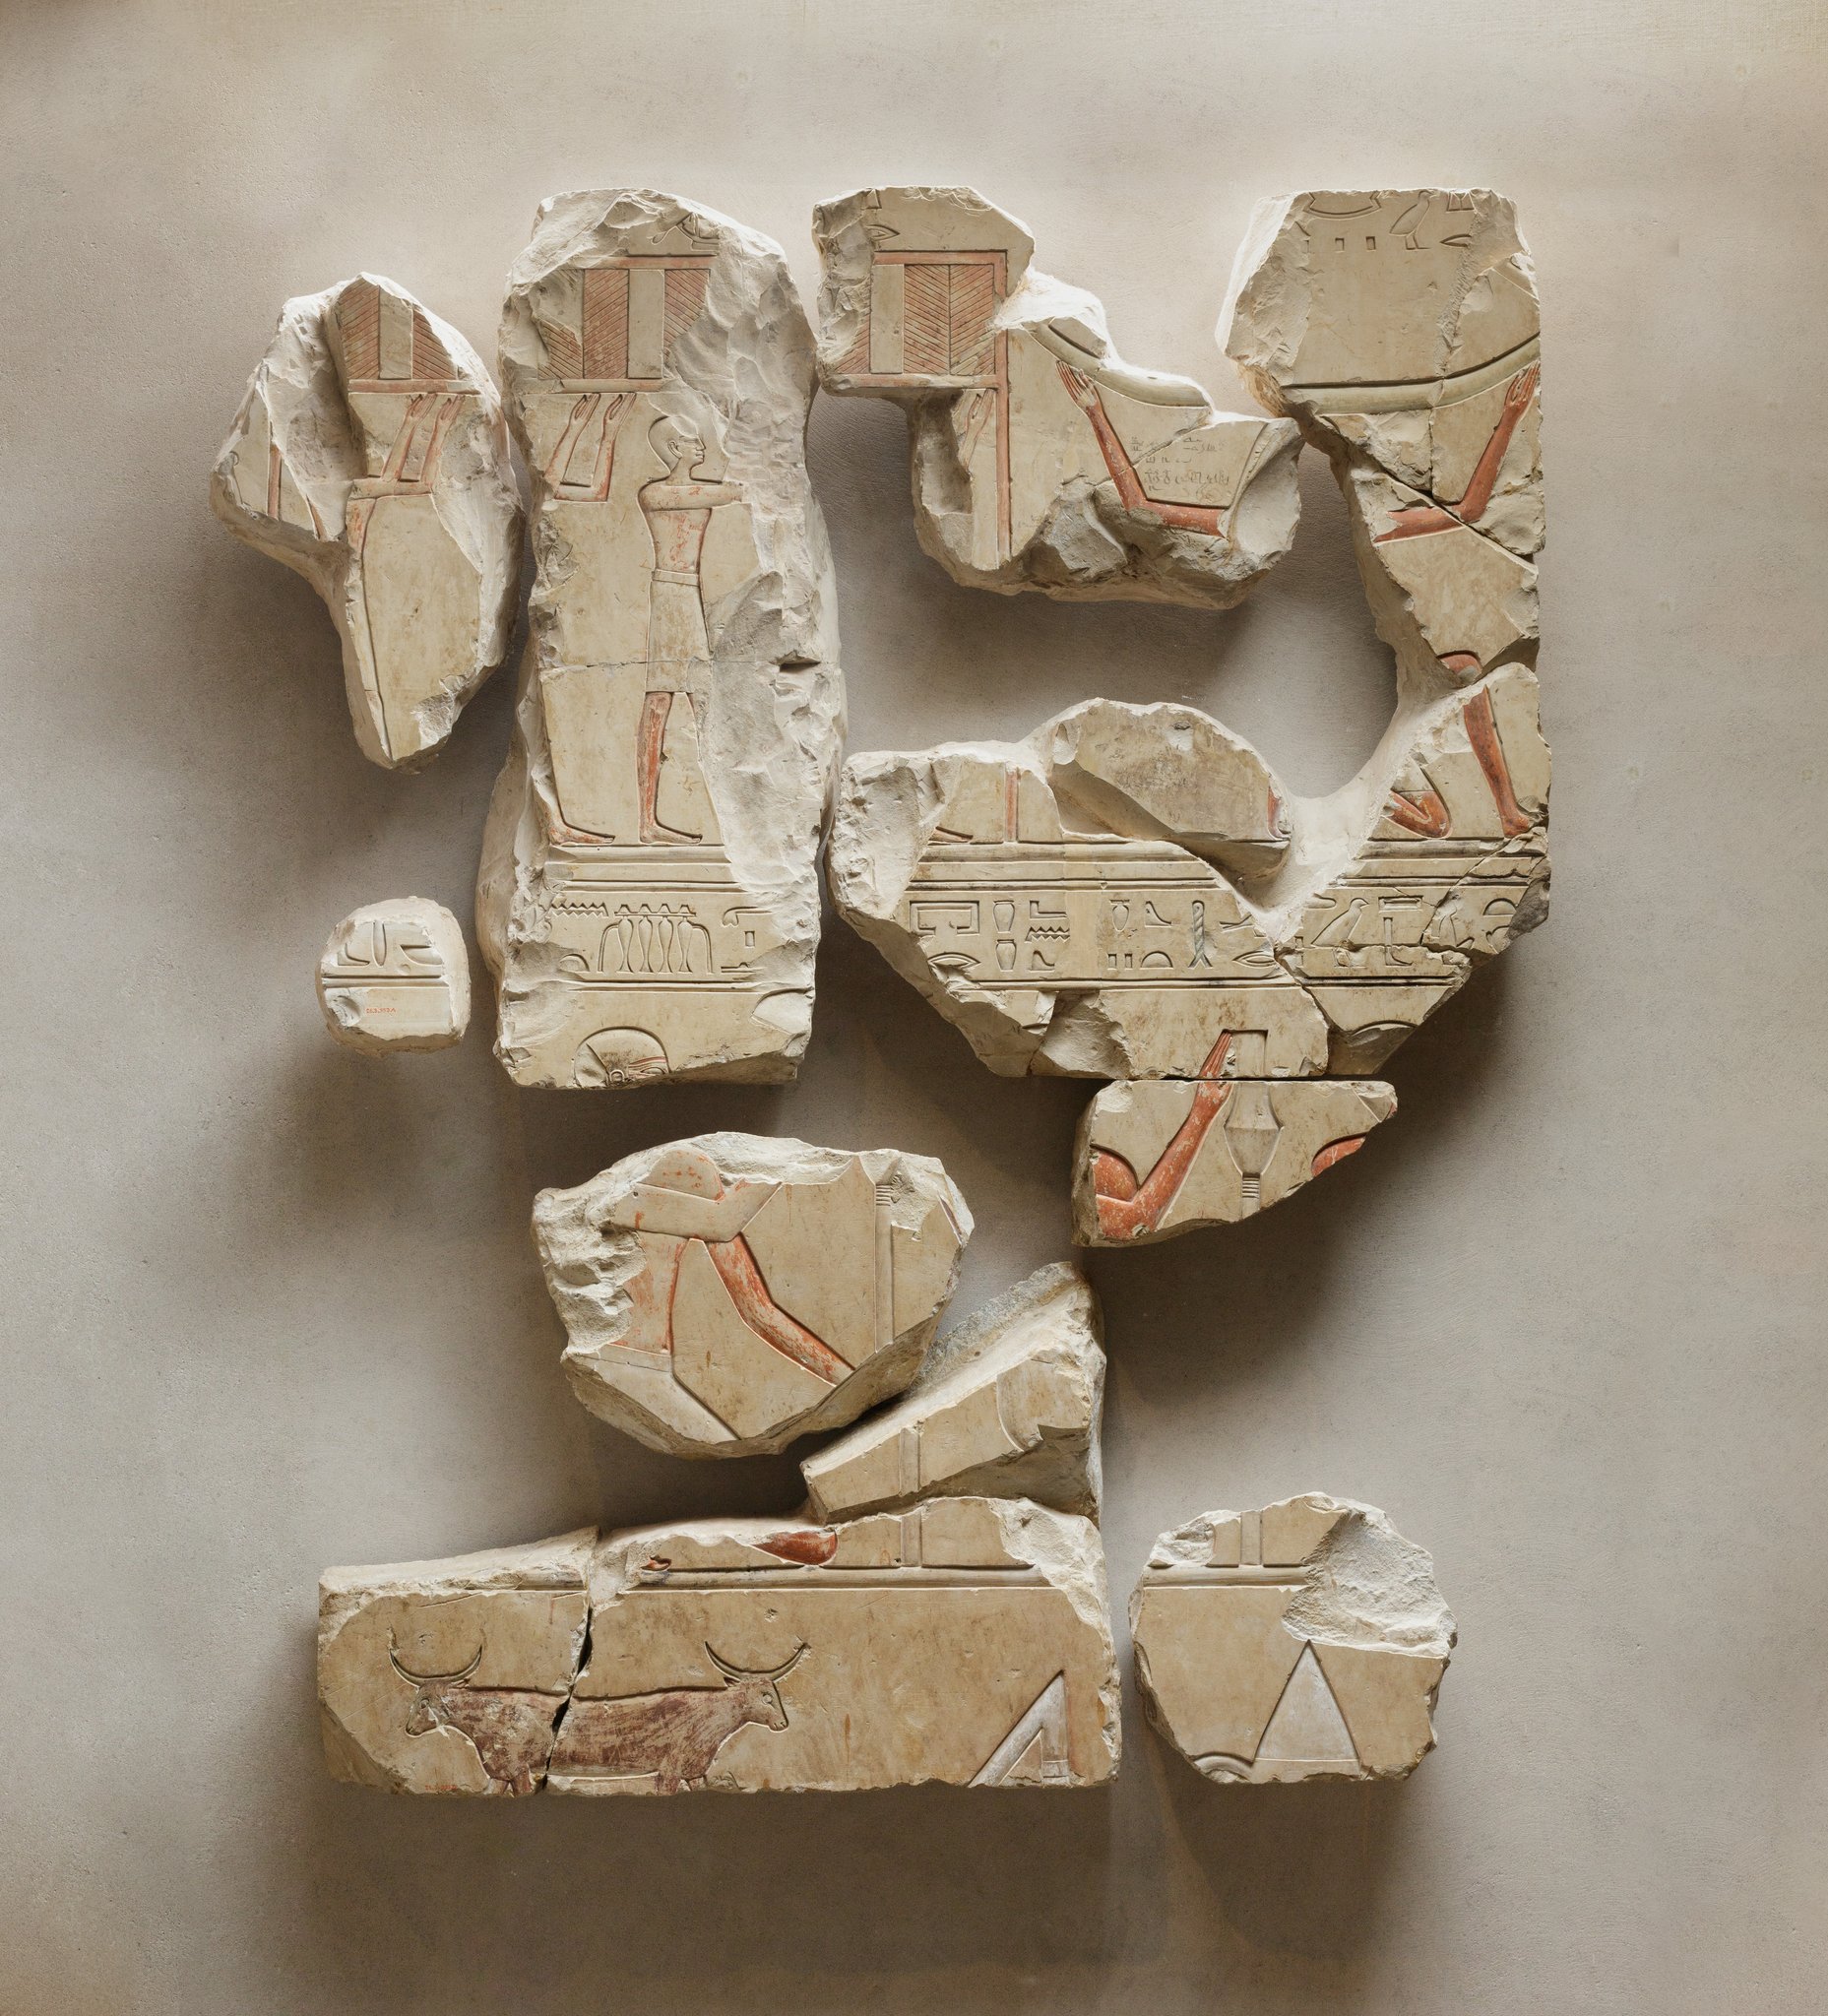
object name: relief, ritual and sacred emblem, neferu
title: Relief from the tomb of Queen Neferu depicting rituals and sacred emblems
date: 2051-2030 BCE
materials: limestone, paint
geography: egypt